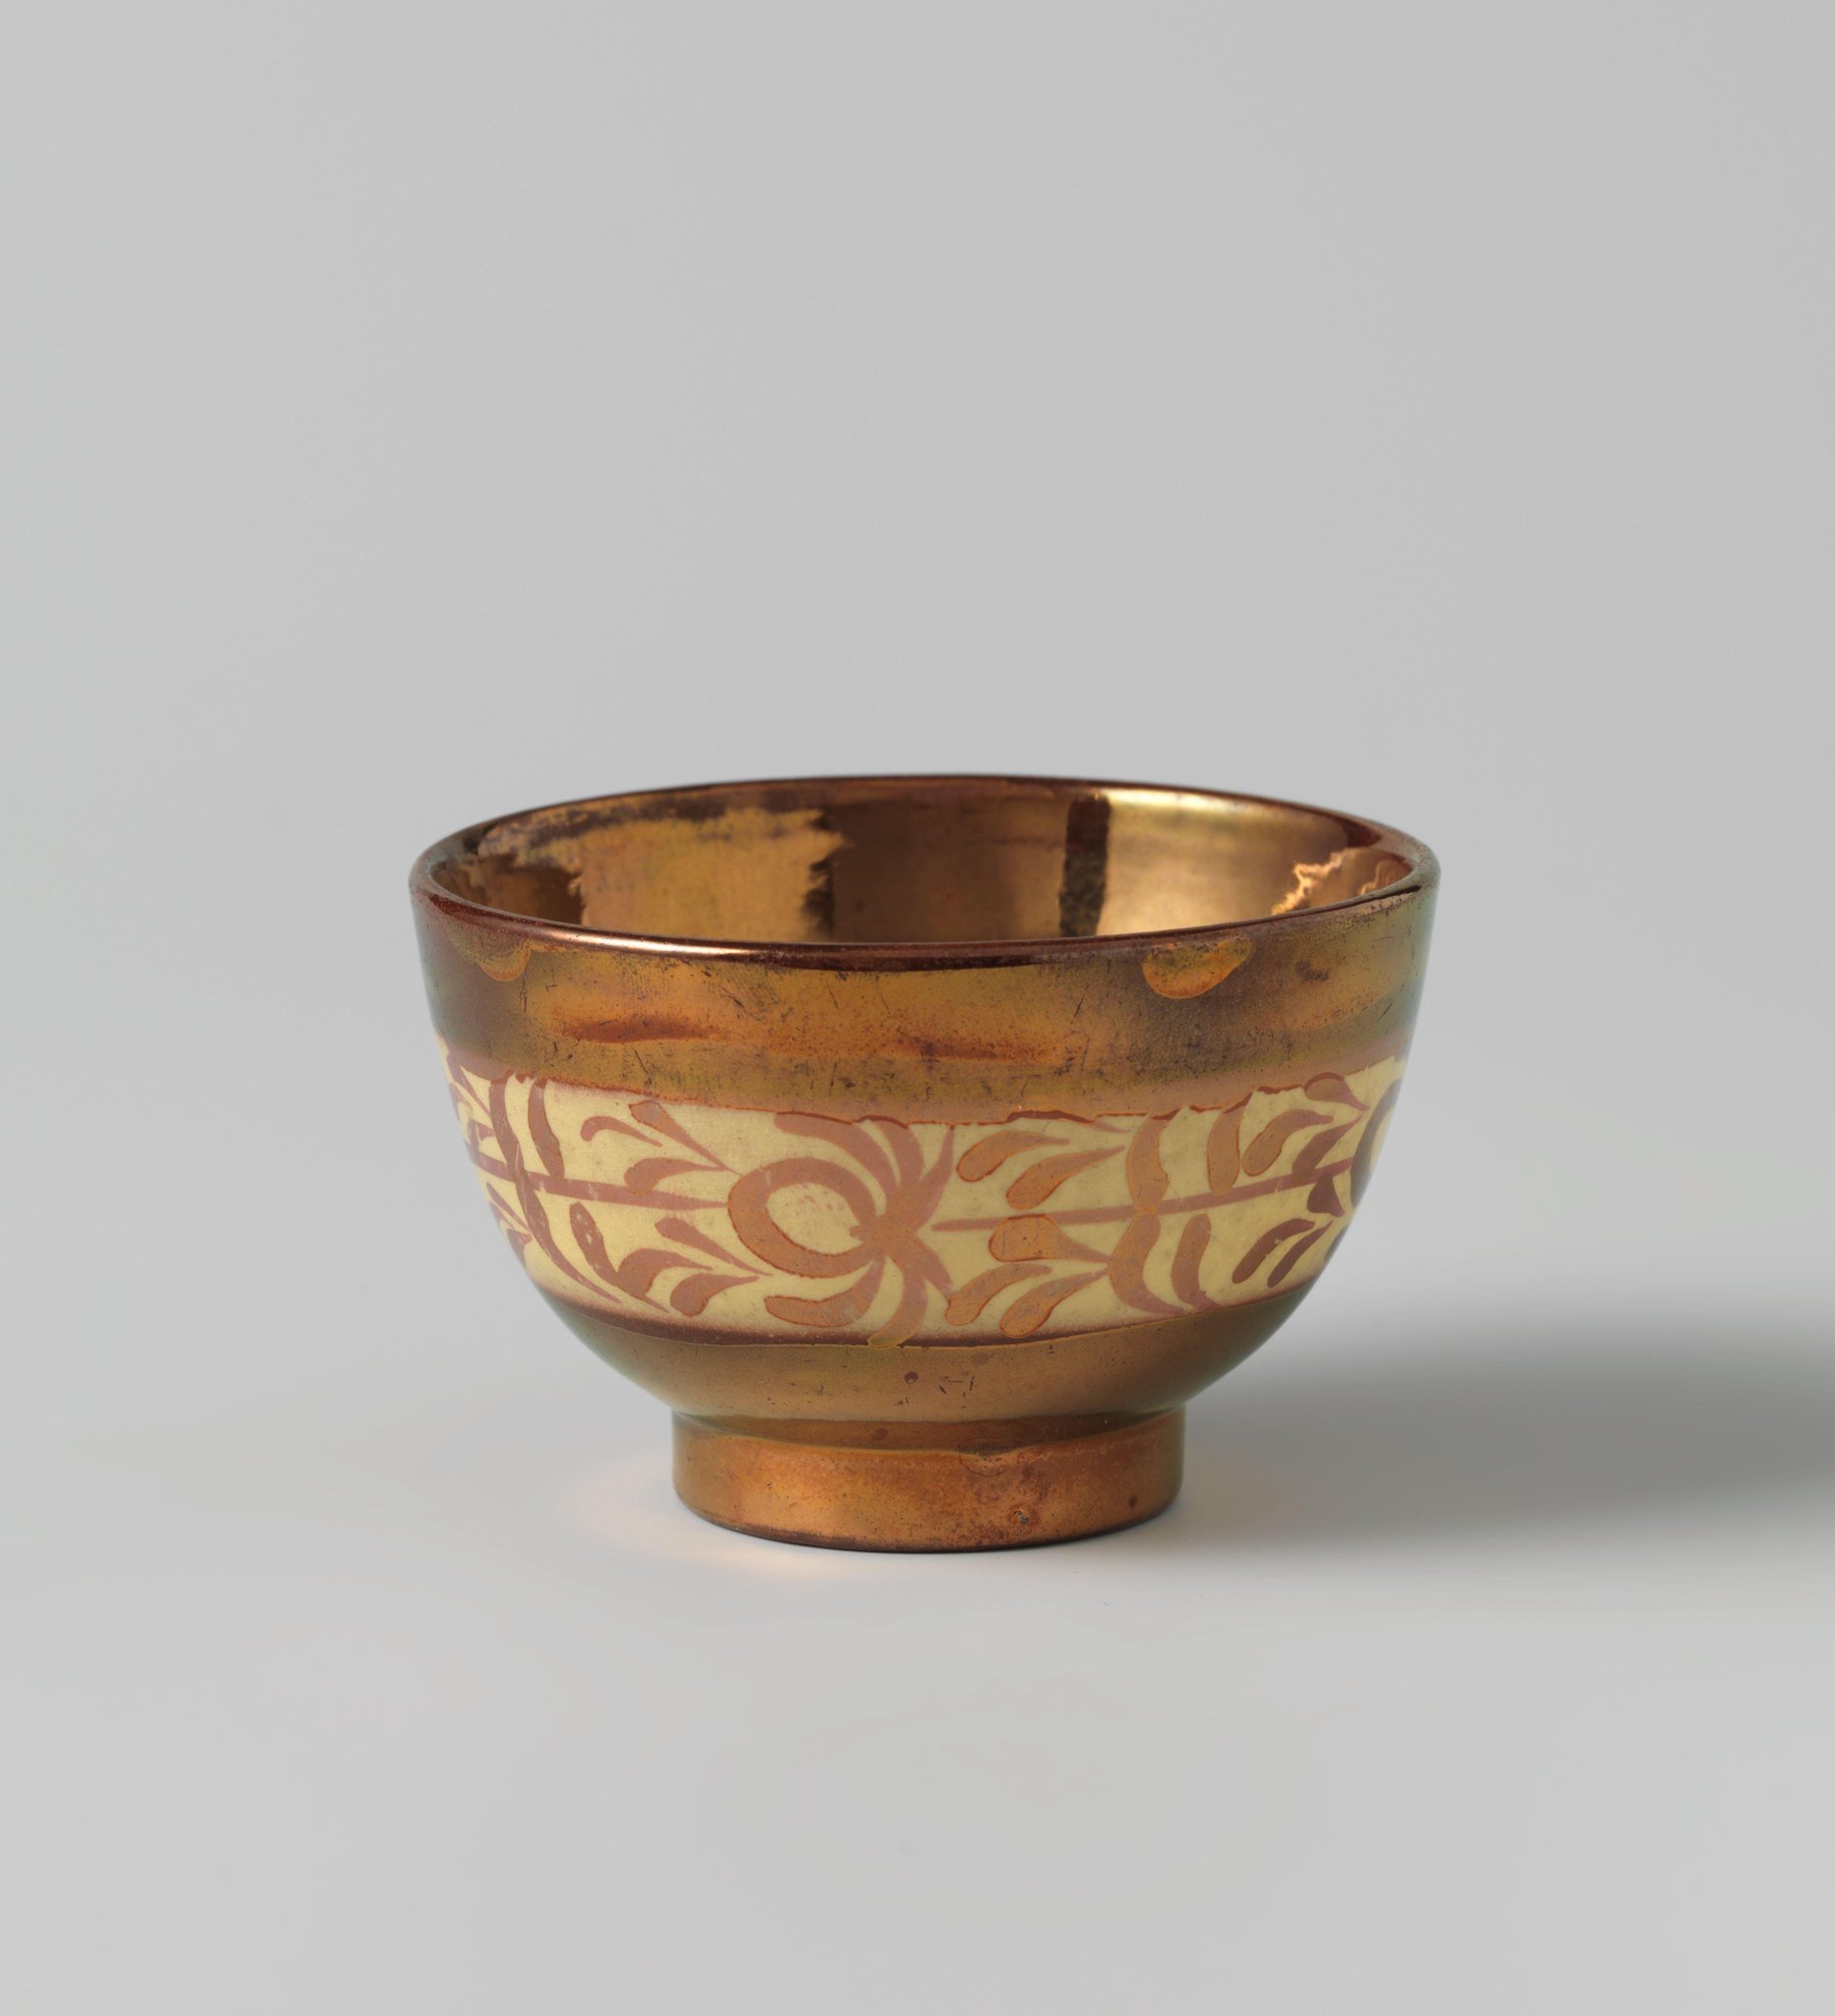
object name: cup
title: Kop zonder oor, met bloemen en bladeren in goud tegen een uitgespaarde gele band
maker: petrus regout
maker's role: plateelbakker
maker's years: 1801-1879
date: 1860-1890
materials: stoneware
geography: maastricht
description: Kop zonder oor van aardewerk, goudsteen. Over de buitenzijde van de wand loopt een band met bloemen en bladeren in lilaluster, tegen een uitgespaarde gele achtergrond. De rest van de kop is bedekt met lilaluster.